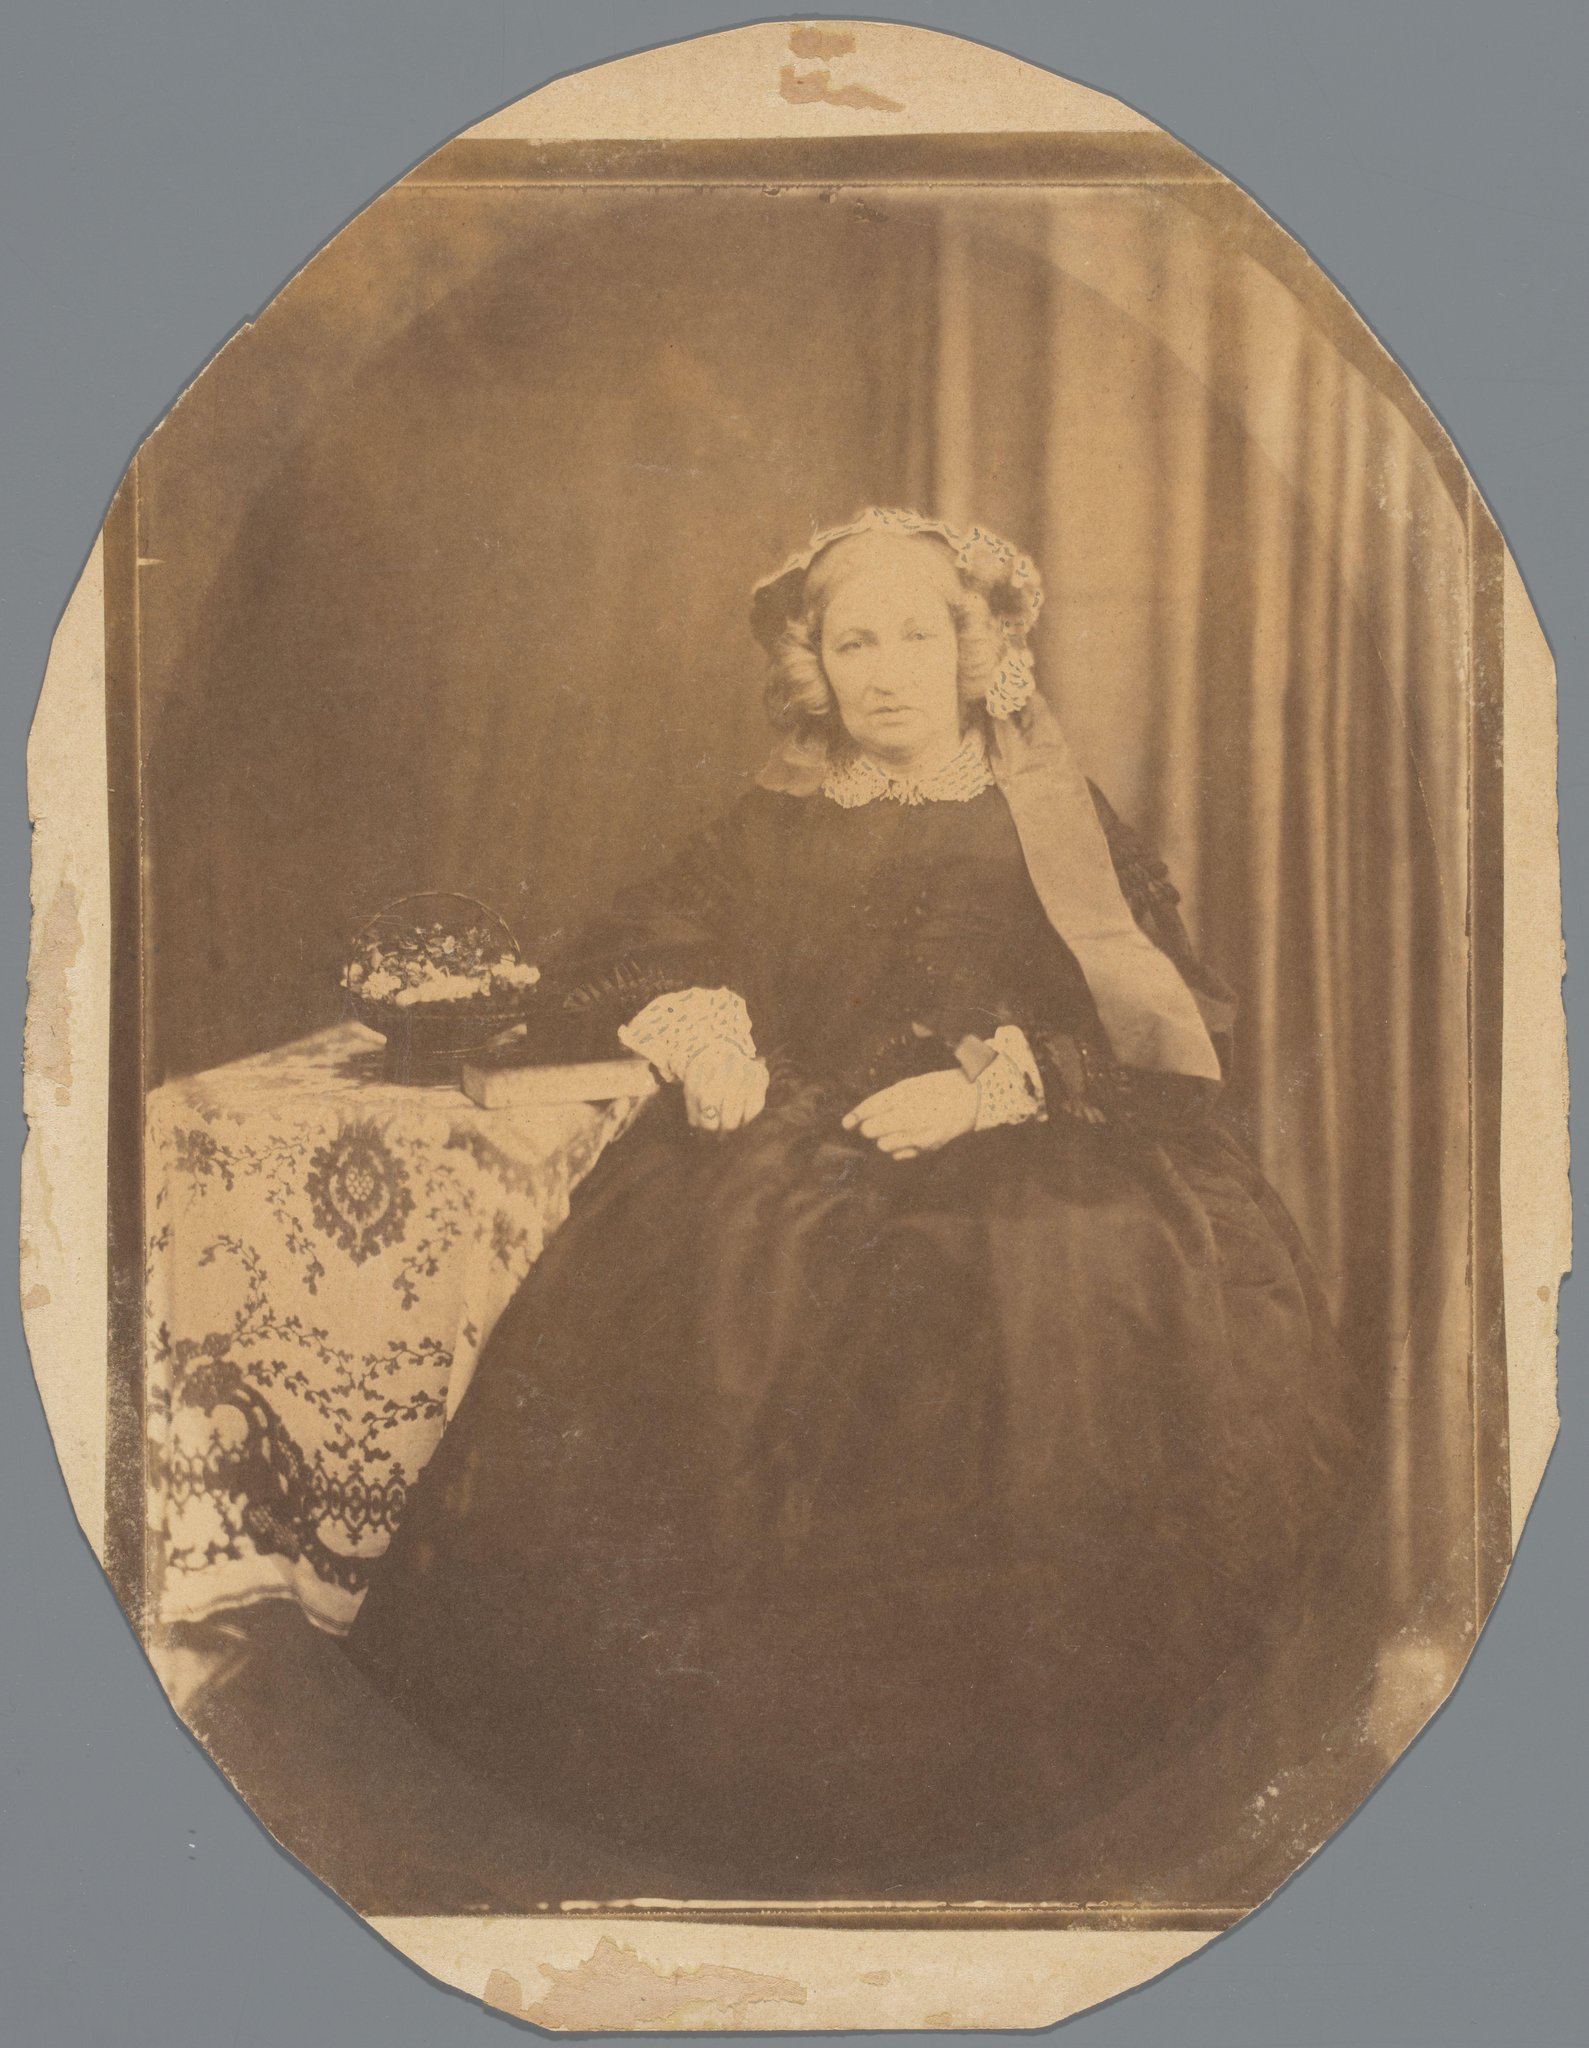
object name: photograph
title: Portret van Anne Gesiena Nije Doorwaard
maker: Anonymous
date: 1850-1870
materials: cardboard, photographic support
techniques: salted paper print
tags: historical persons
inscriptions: annotation: ‘Grootmoeder Anne Gesiena Nije Doorwaard’